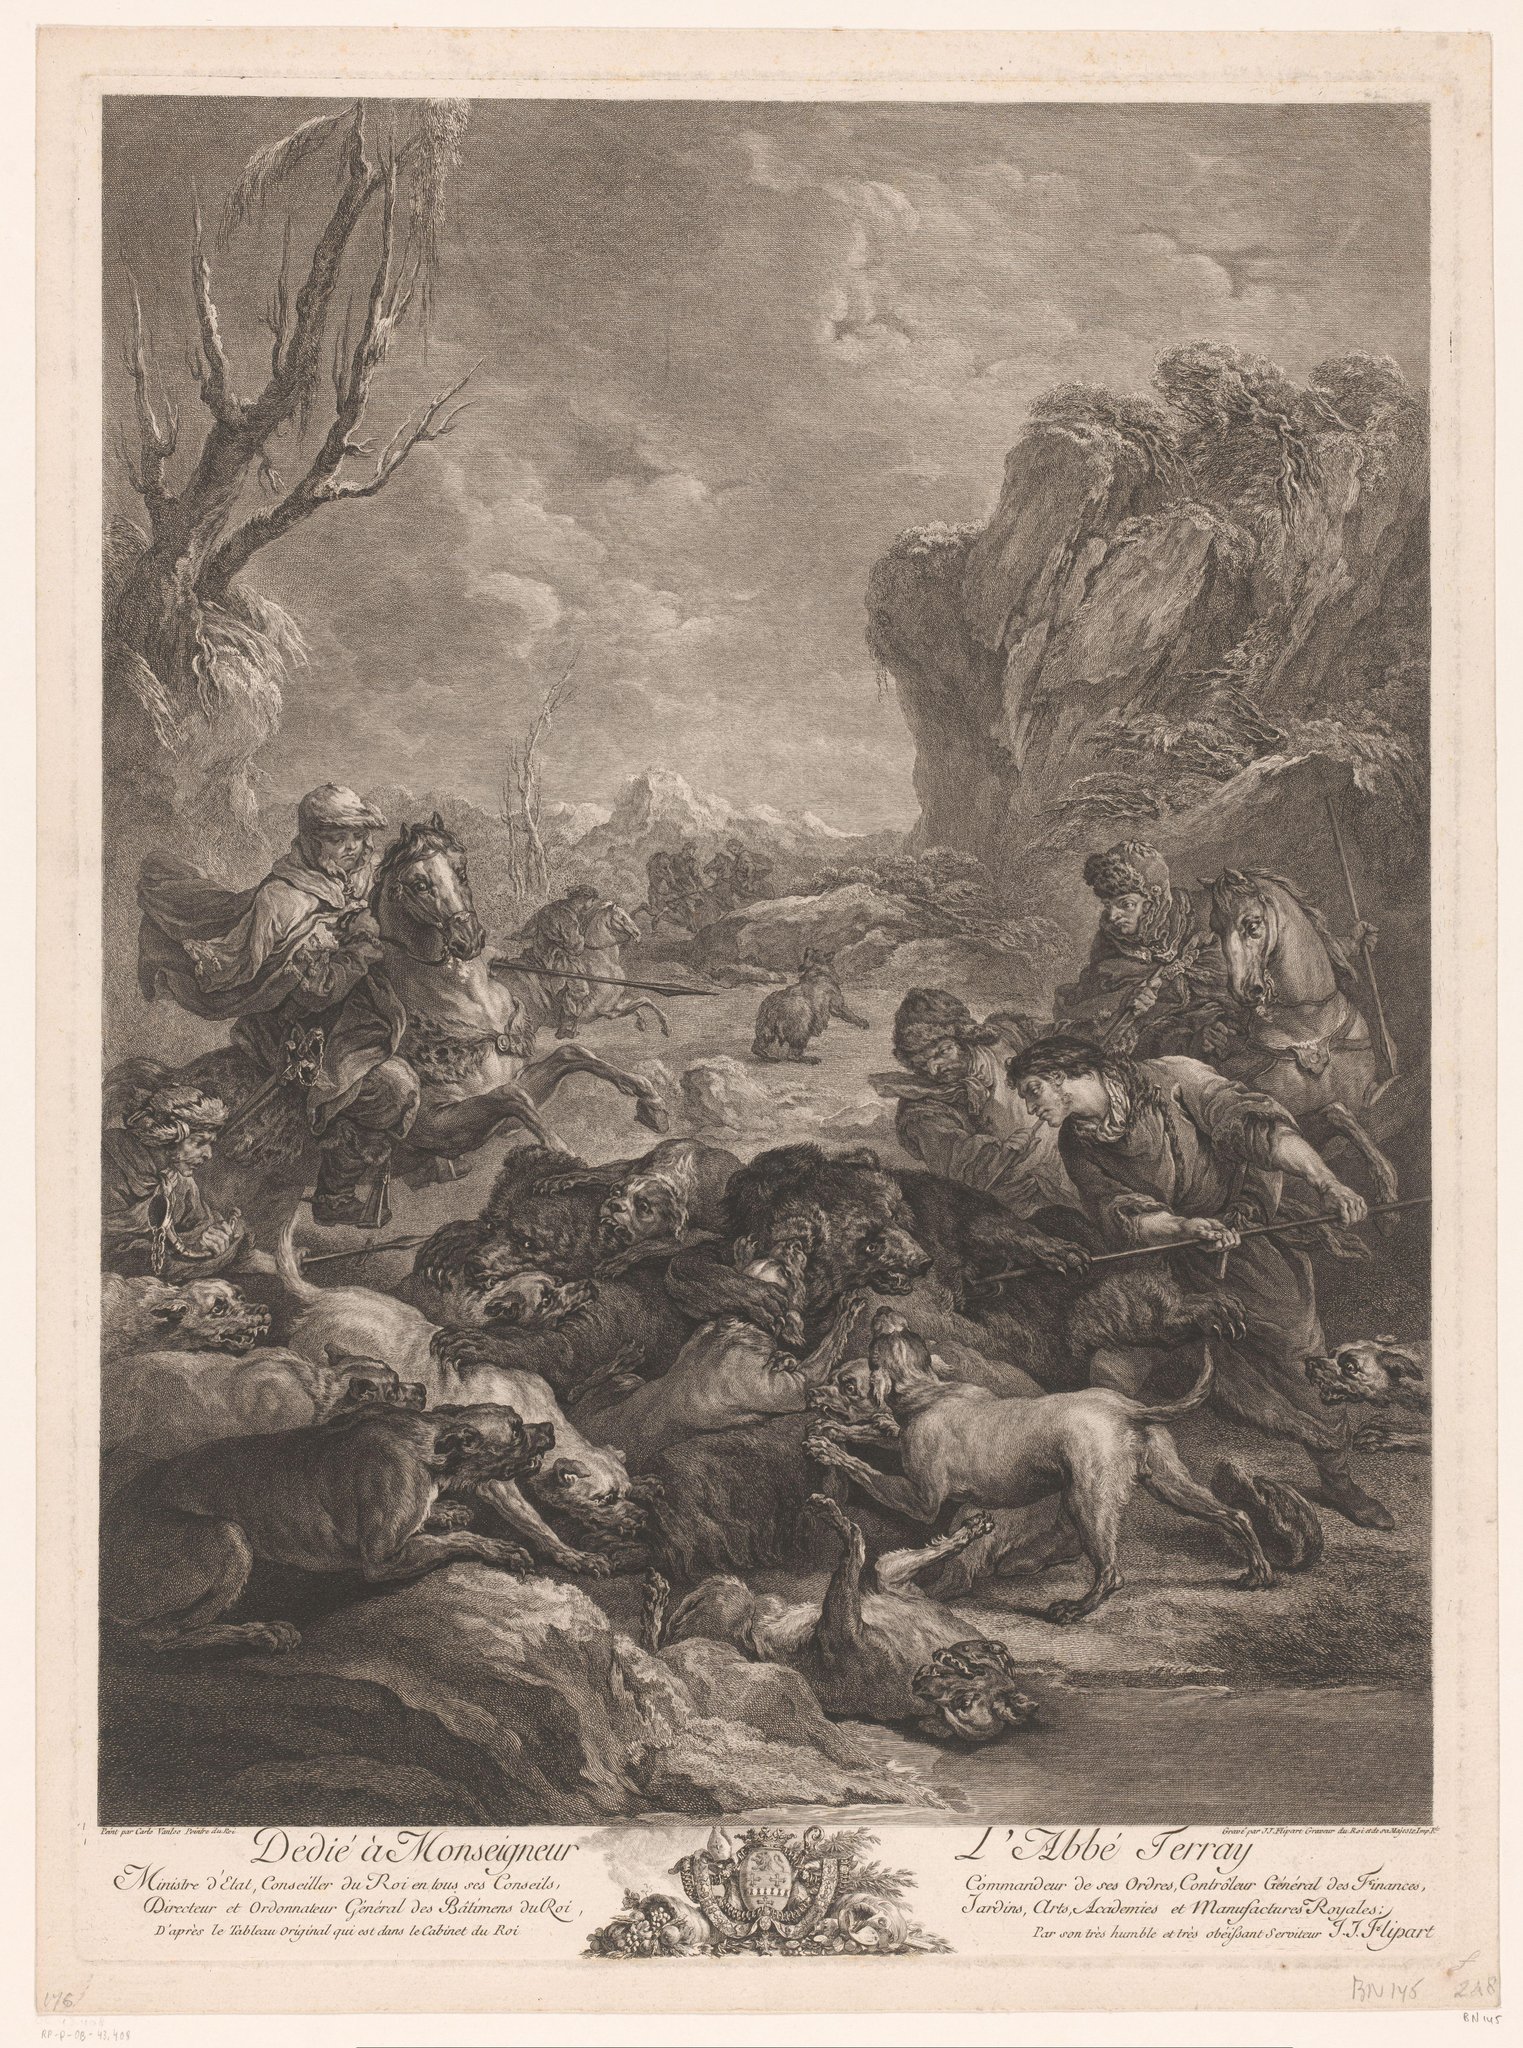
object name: print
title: Jagers en jachthonden houden een beer in bedwang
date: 1773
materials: paper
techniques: engraving, etching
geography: france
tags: hunting dogs, hunt ~ predatory animals (fox, lion), beasts of prey, predatory animals: bear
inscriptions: collector's mark: Lugt 2228